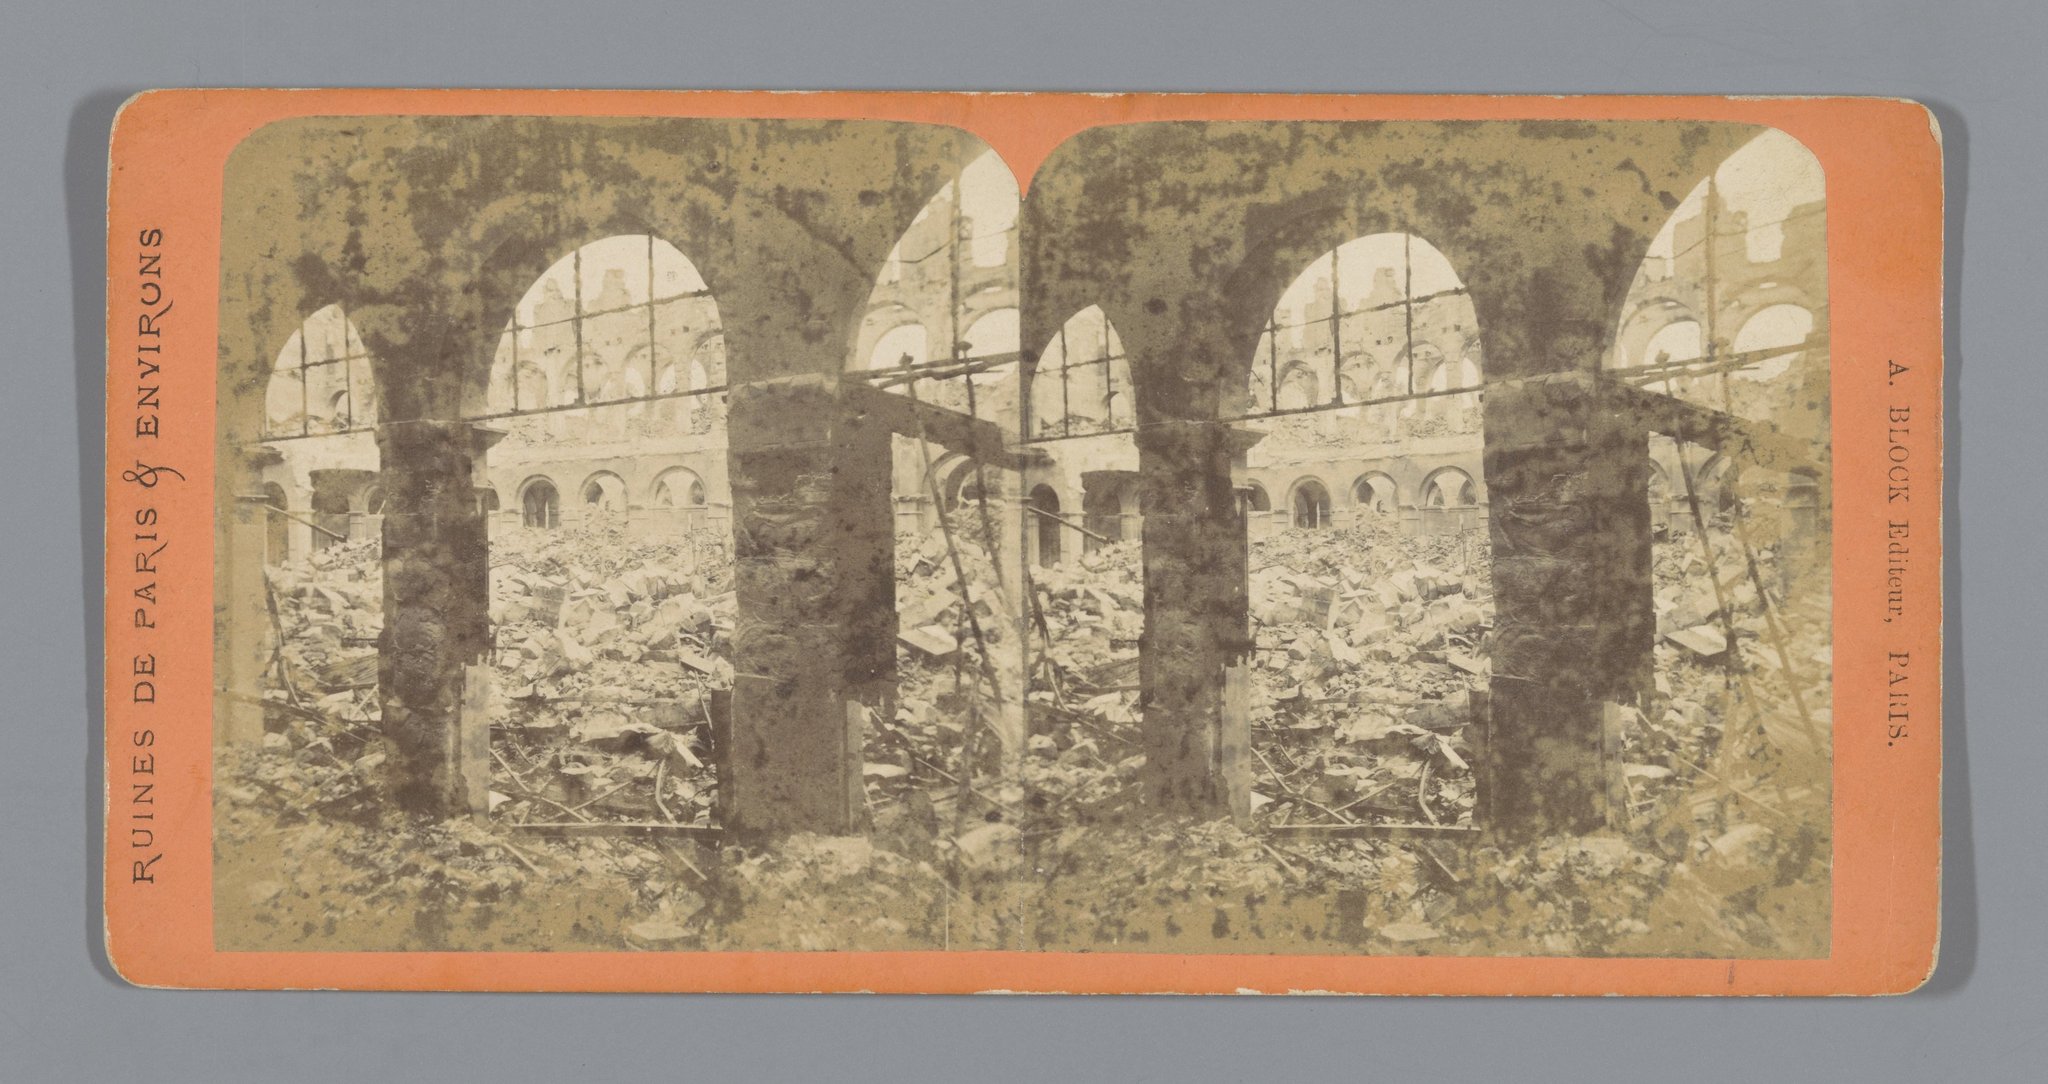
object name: stereograph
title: Ruines de Paris & environs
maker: adolphe block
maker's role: publisher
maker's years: 1829-1918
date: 1871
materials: cardboard, photographic support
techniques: albumen print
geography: paris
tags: ruin of a building ~ architecture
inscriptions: inscription: ‘Grenier d'abondance’